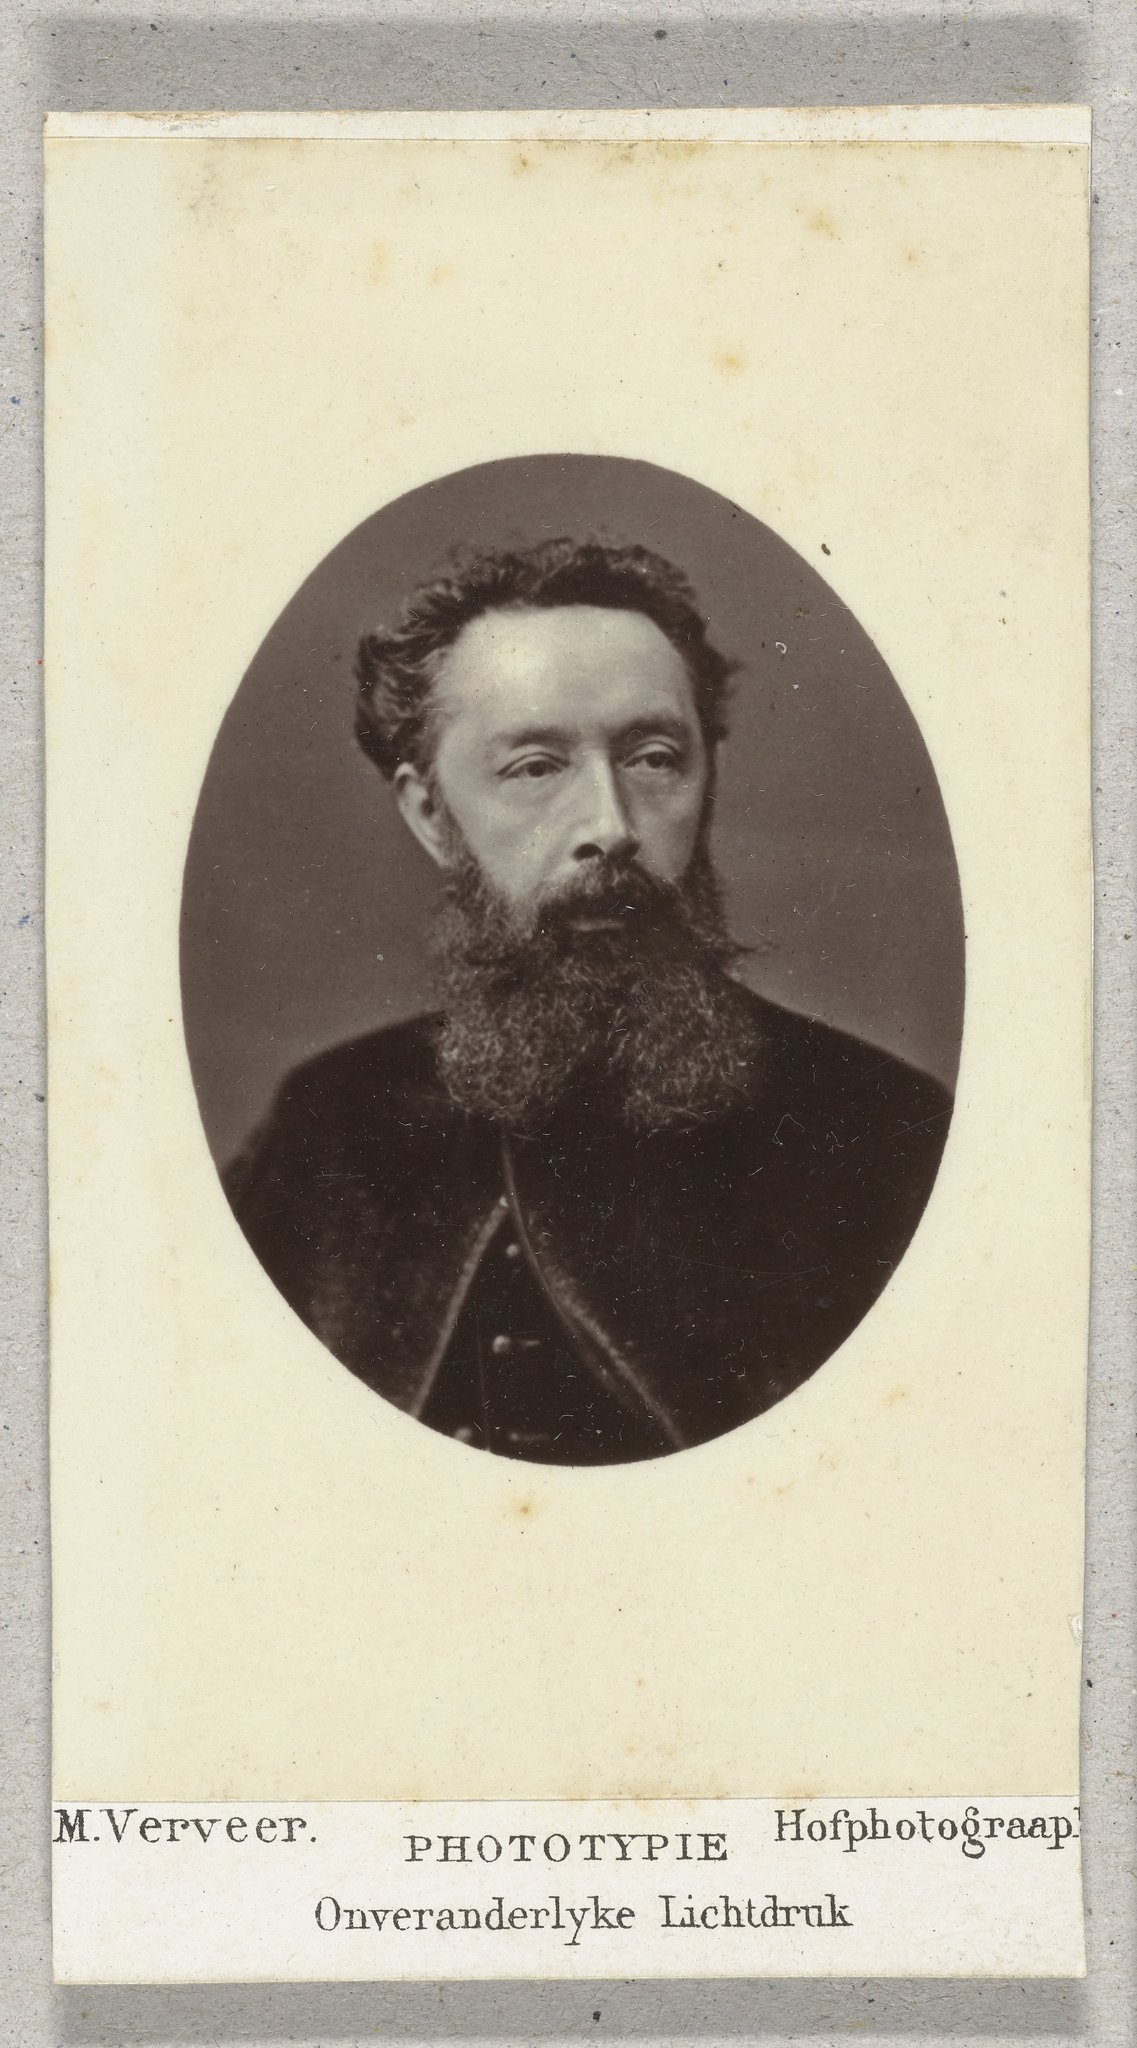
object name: carte de visite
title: Zelfportret van Maurits Verveer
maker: maurits verveer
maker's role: painter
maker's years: 1817-1903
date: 1850-1875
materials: cardboard, paper, photographic support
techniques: carbon print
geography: the hague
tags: the hague, painter, maurits verveer, historical persons, portrait, self-portrait of artist, portrait, self-portrait of photographer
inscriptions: name: ‘M. Vreveer photographie de L.L.M.M. le Roi er la Reine des Pays Bas 52. Zeestraat, vis a vis du Willemspark 52 La Haye’, name: ‘M. Verveer Hofphotograaph. Phototypie onveranderlijke lichtdruk’